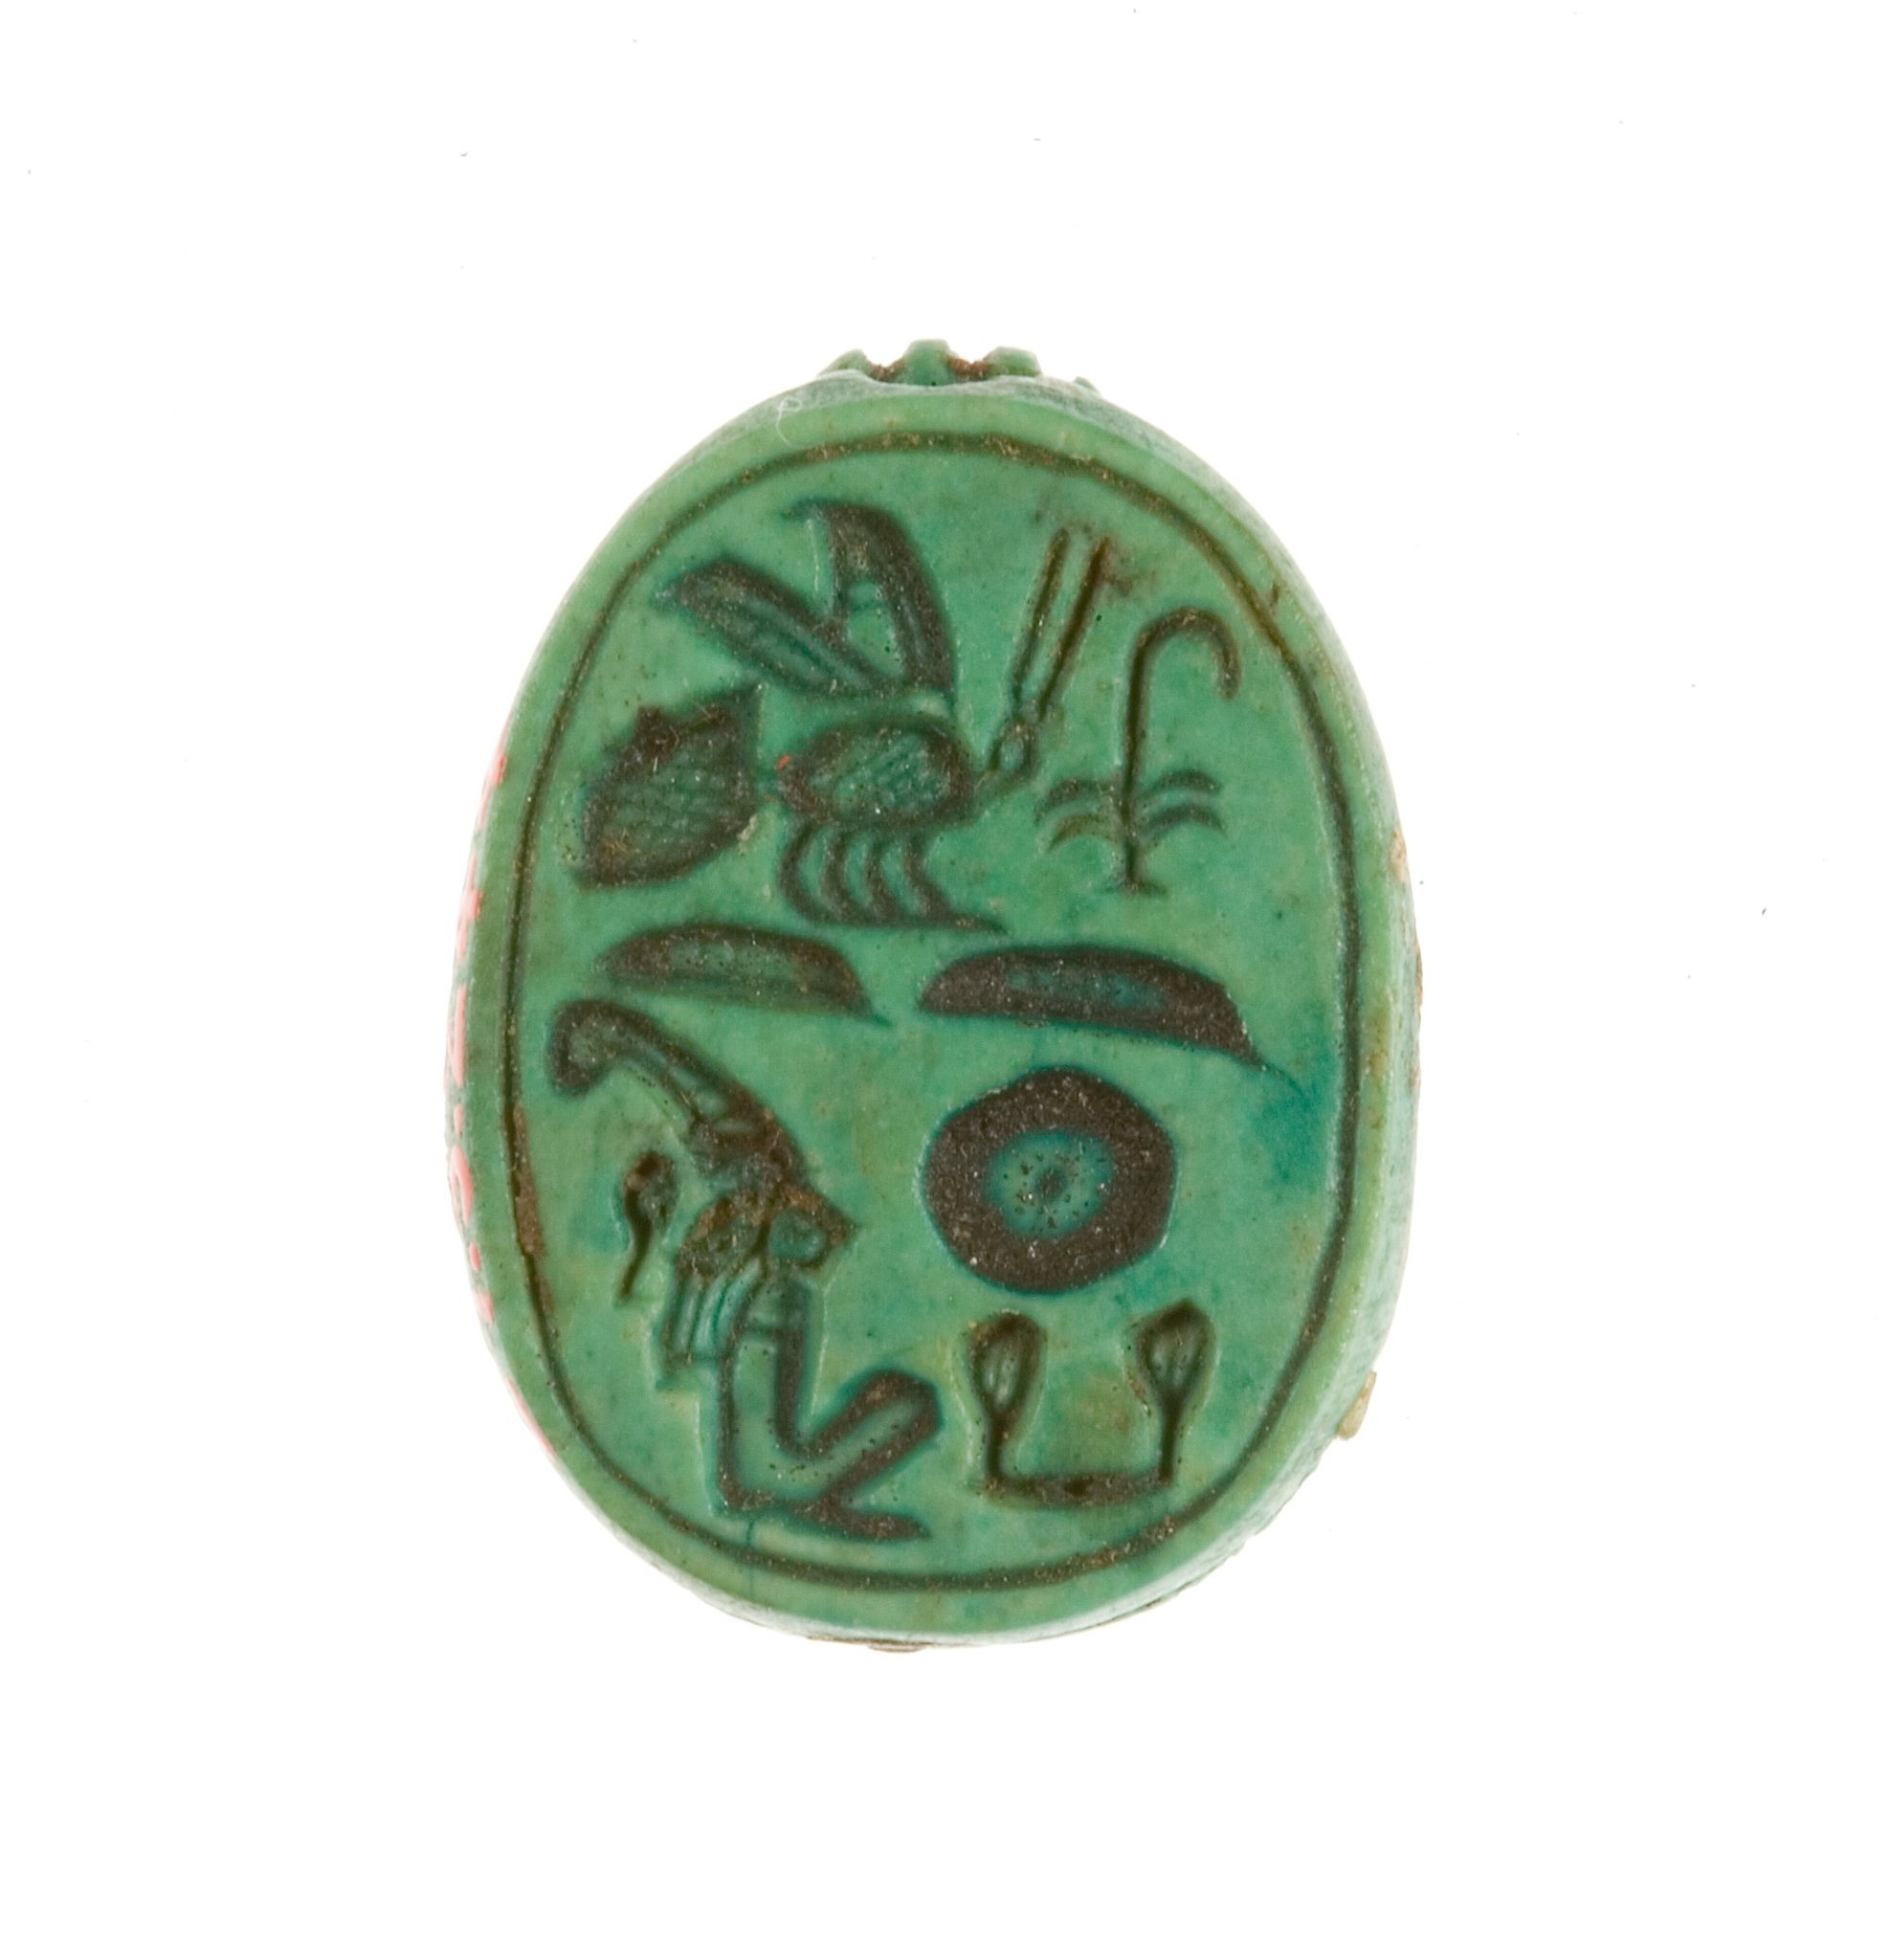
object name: scarab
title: Scarab Inscribed for the King of Upper and Lower Egypt Maatkare (Hatshepsut)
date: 1479-1458 BCE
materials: stone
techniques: glazing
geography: egypt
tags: hieroglyphs,scarabs